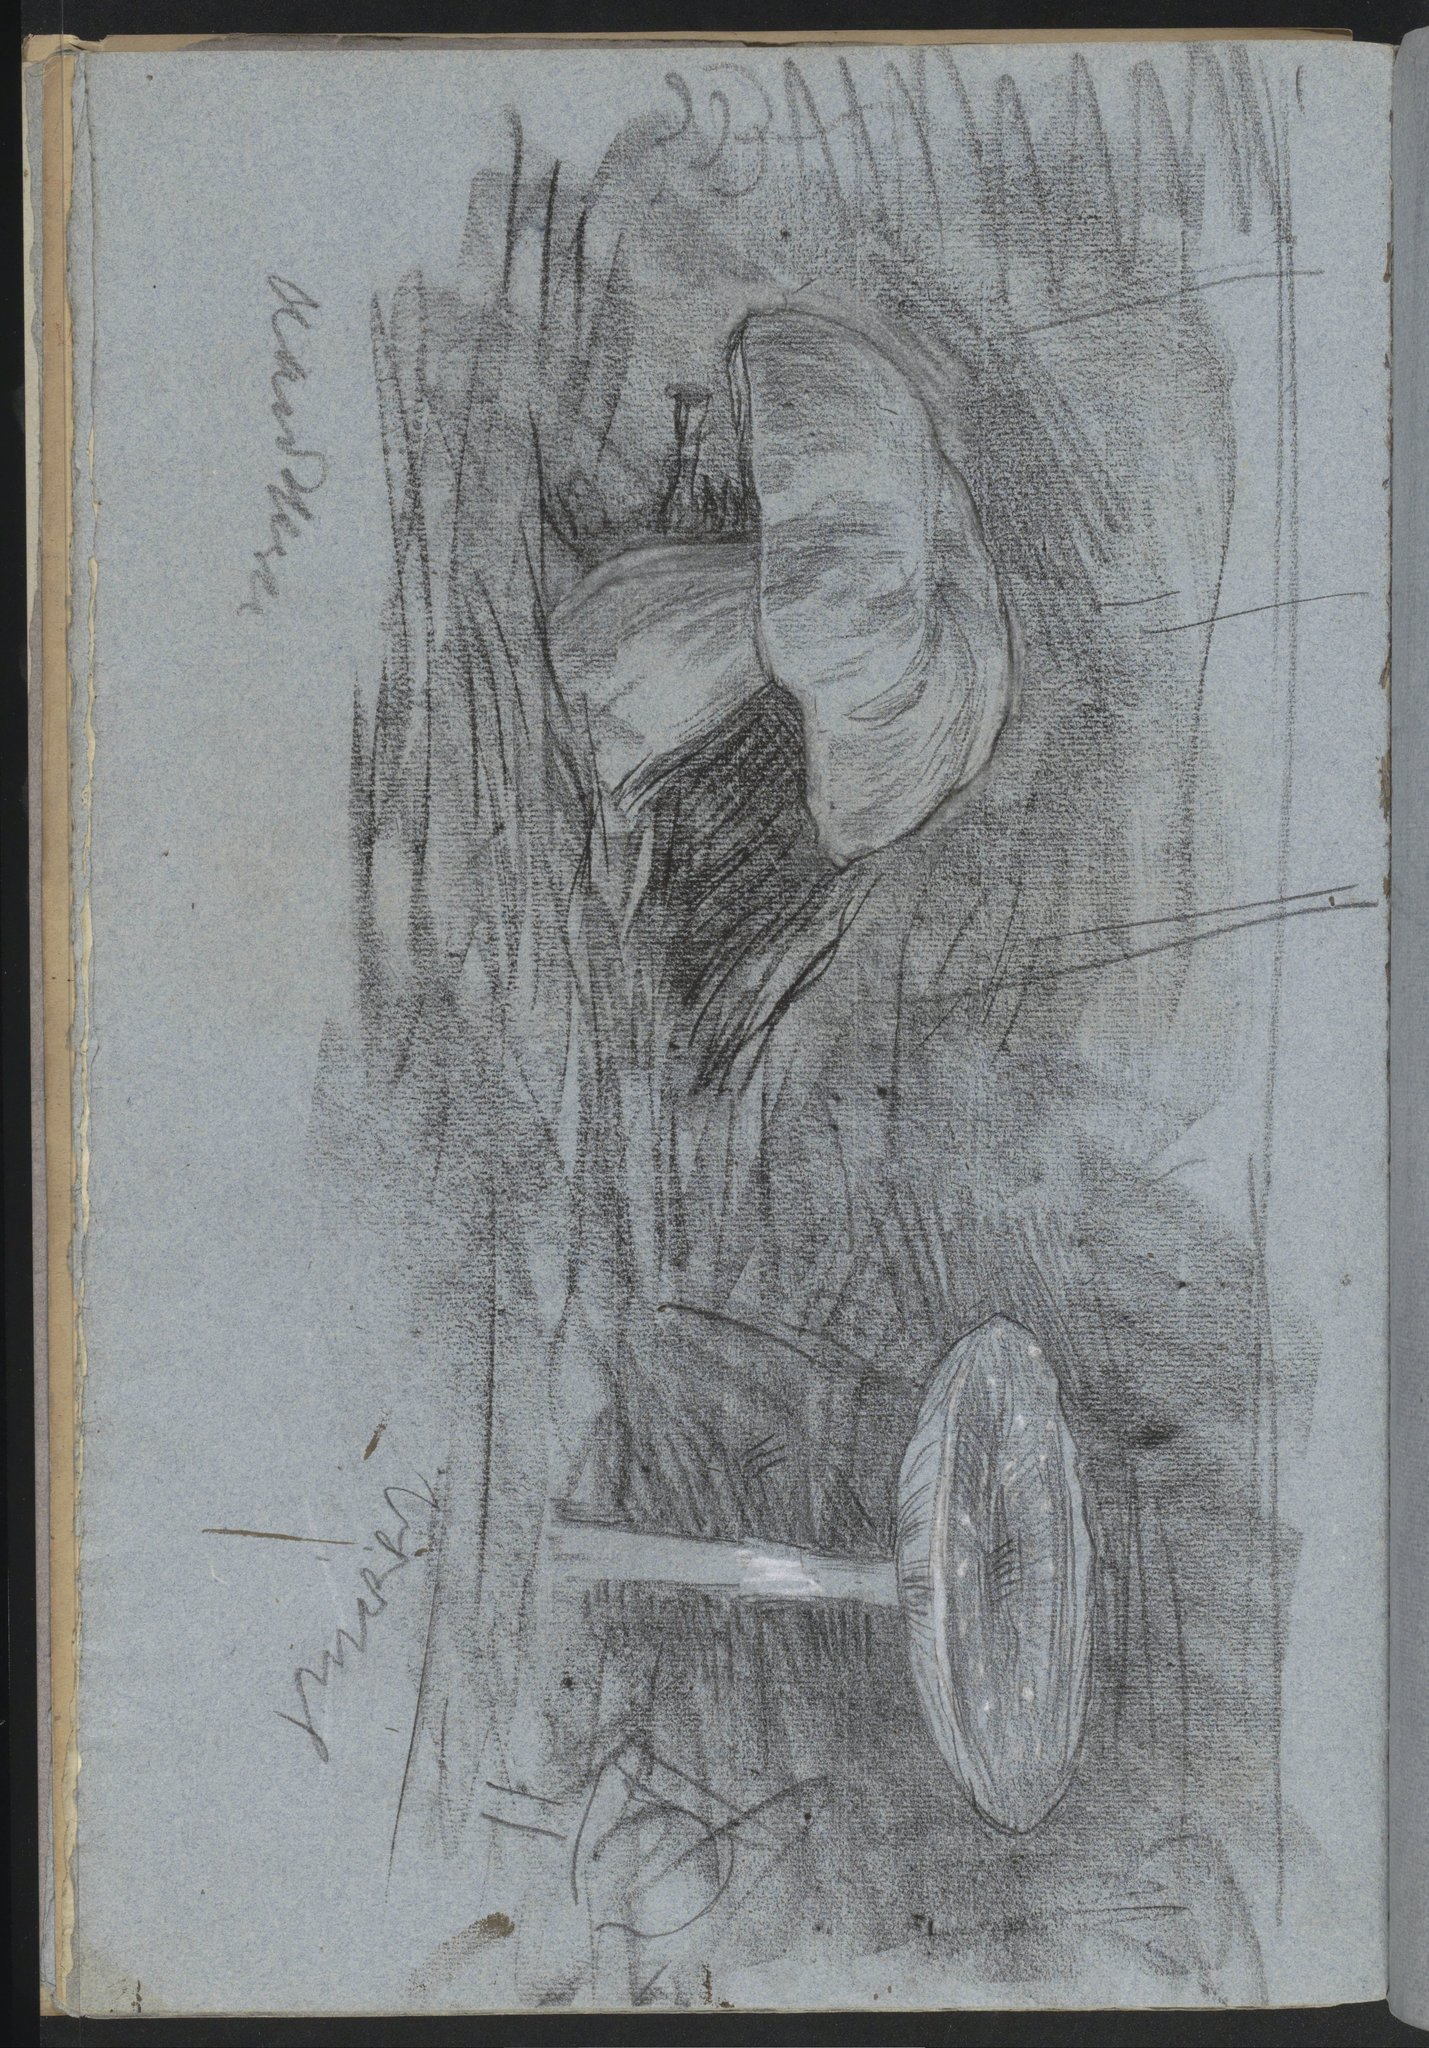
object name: sketchbook leaf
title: Paddenstoelen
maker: jan veth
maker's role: designer, draughtsman, painter, print maker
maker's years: 1864-1925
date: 1874-1925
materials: chalk, paper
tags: mushrooms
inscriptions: annotation: ‘[...]voor[...]’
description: Blad 32 verso uit een schetsboek met 42 bladen.